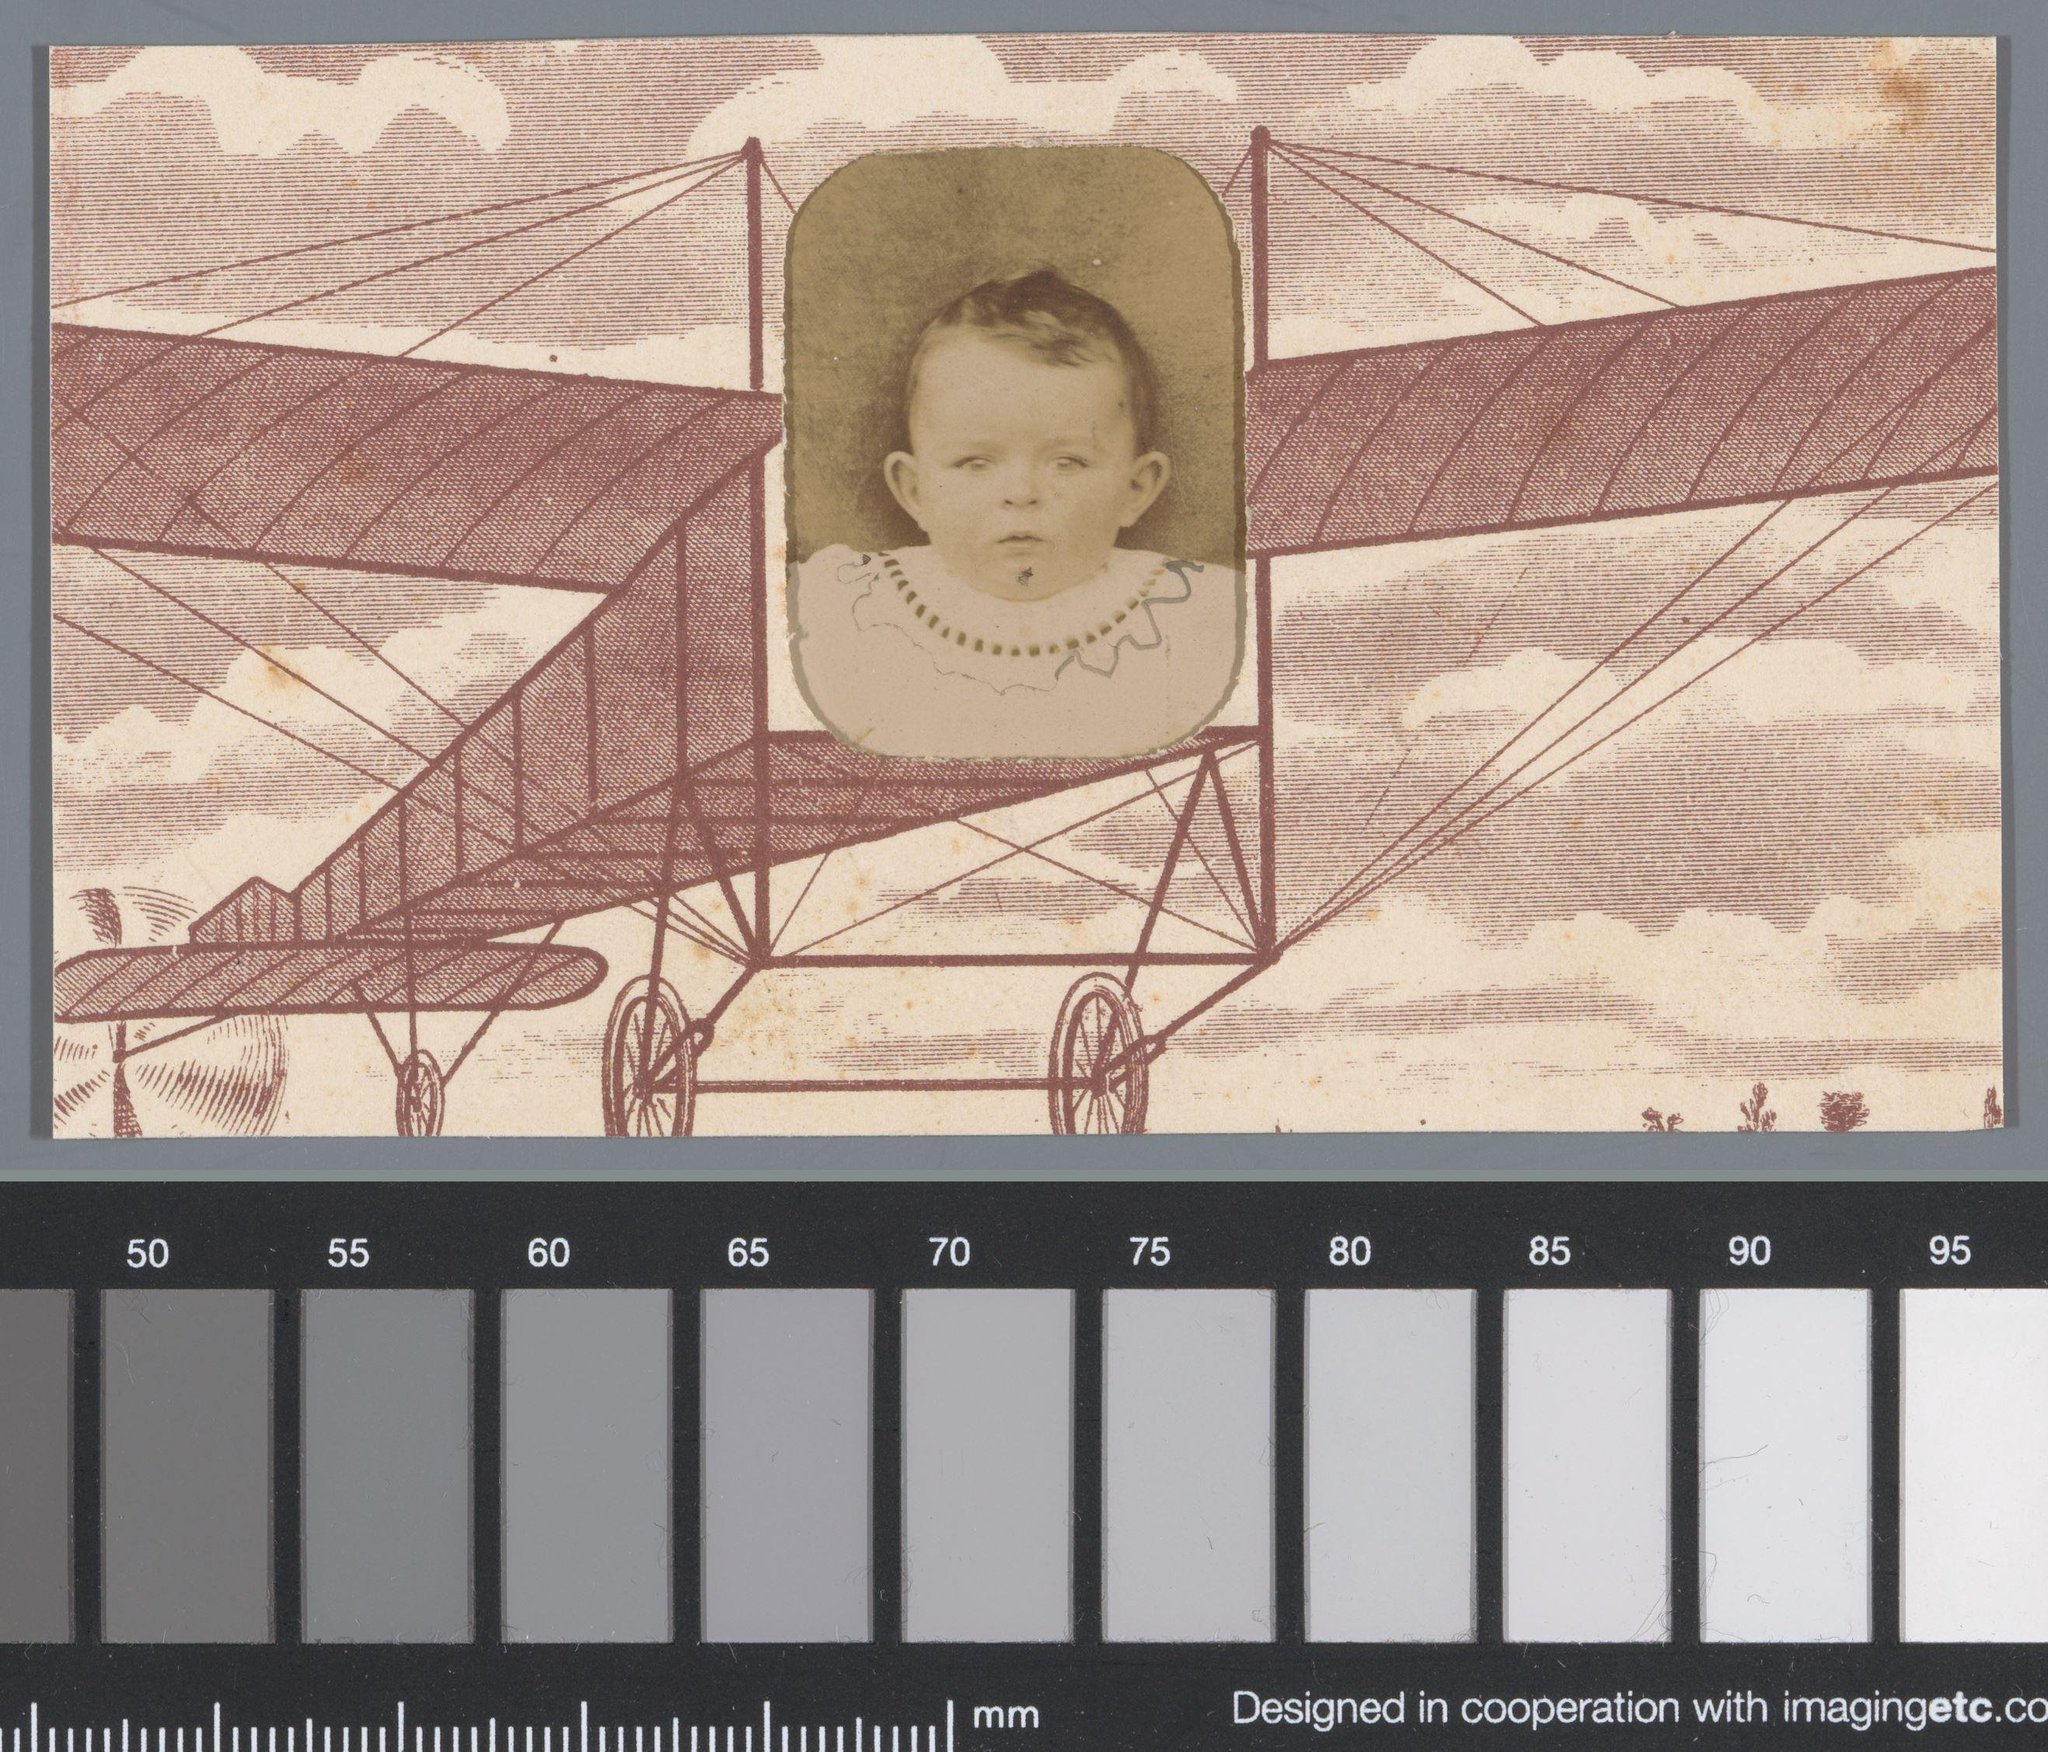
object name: photograph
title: Portret van een onbekend kind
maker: Anonymous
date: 1880-1895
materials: cardboard, photographic support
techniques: albumen print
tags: infant, baby